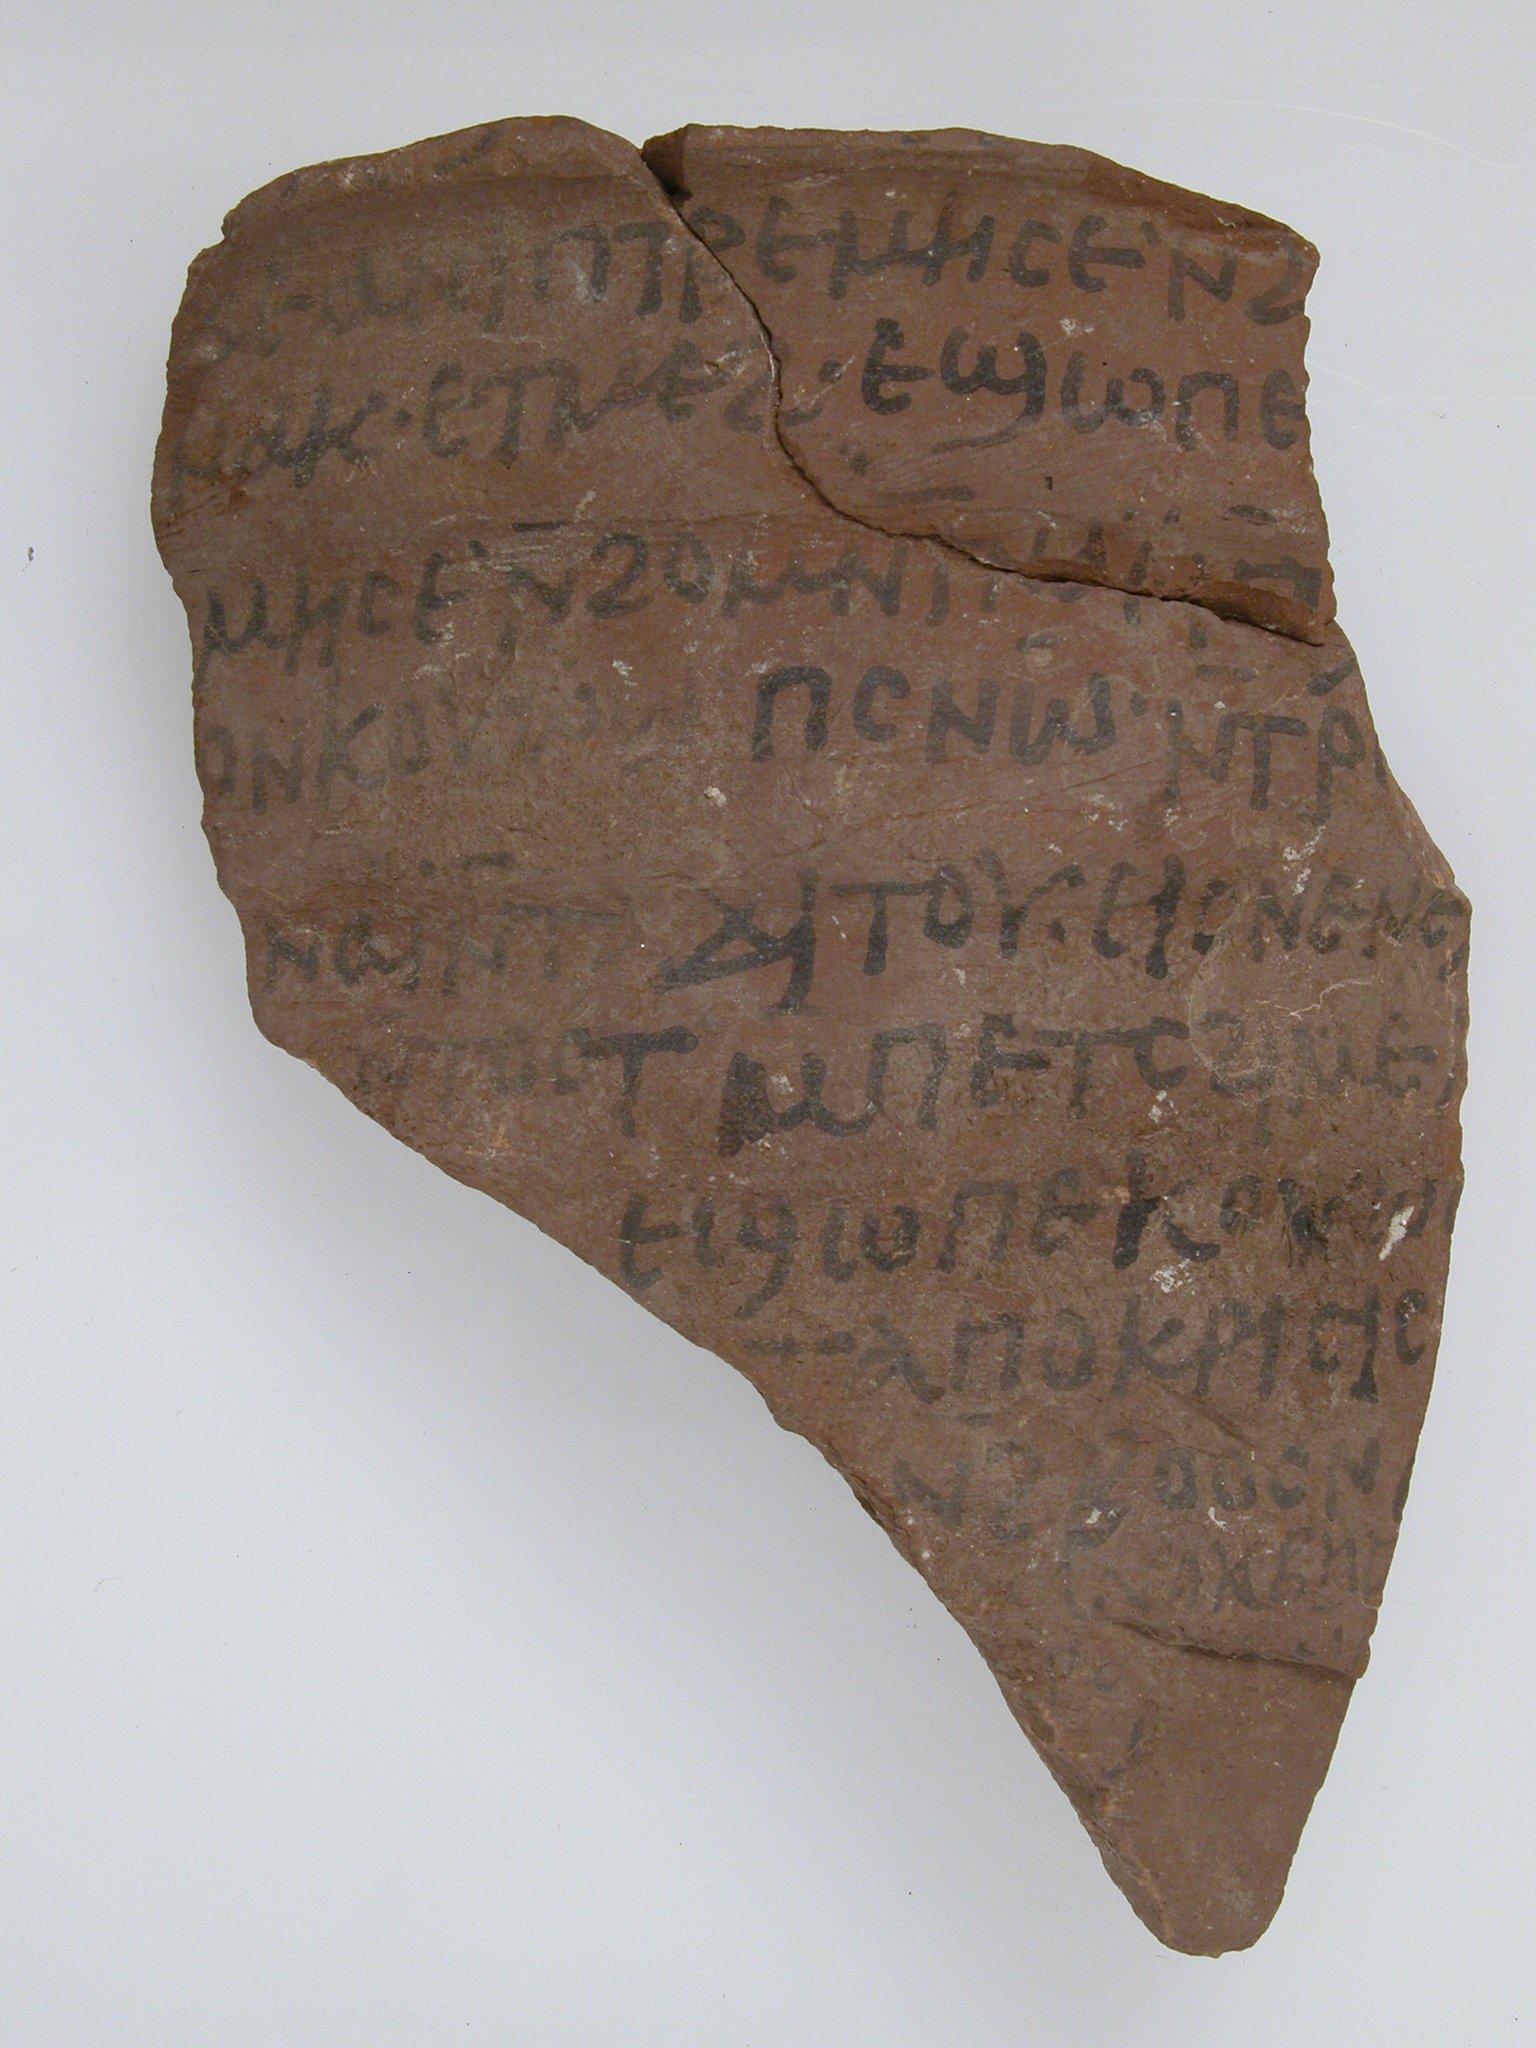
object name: ostrakon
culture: coptic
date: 601-700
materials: ink, pottery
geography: egypt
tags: documents